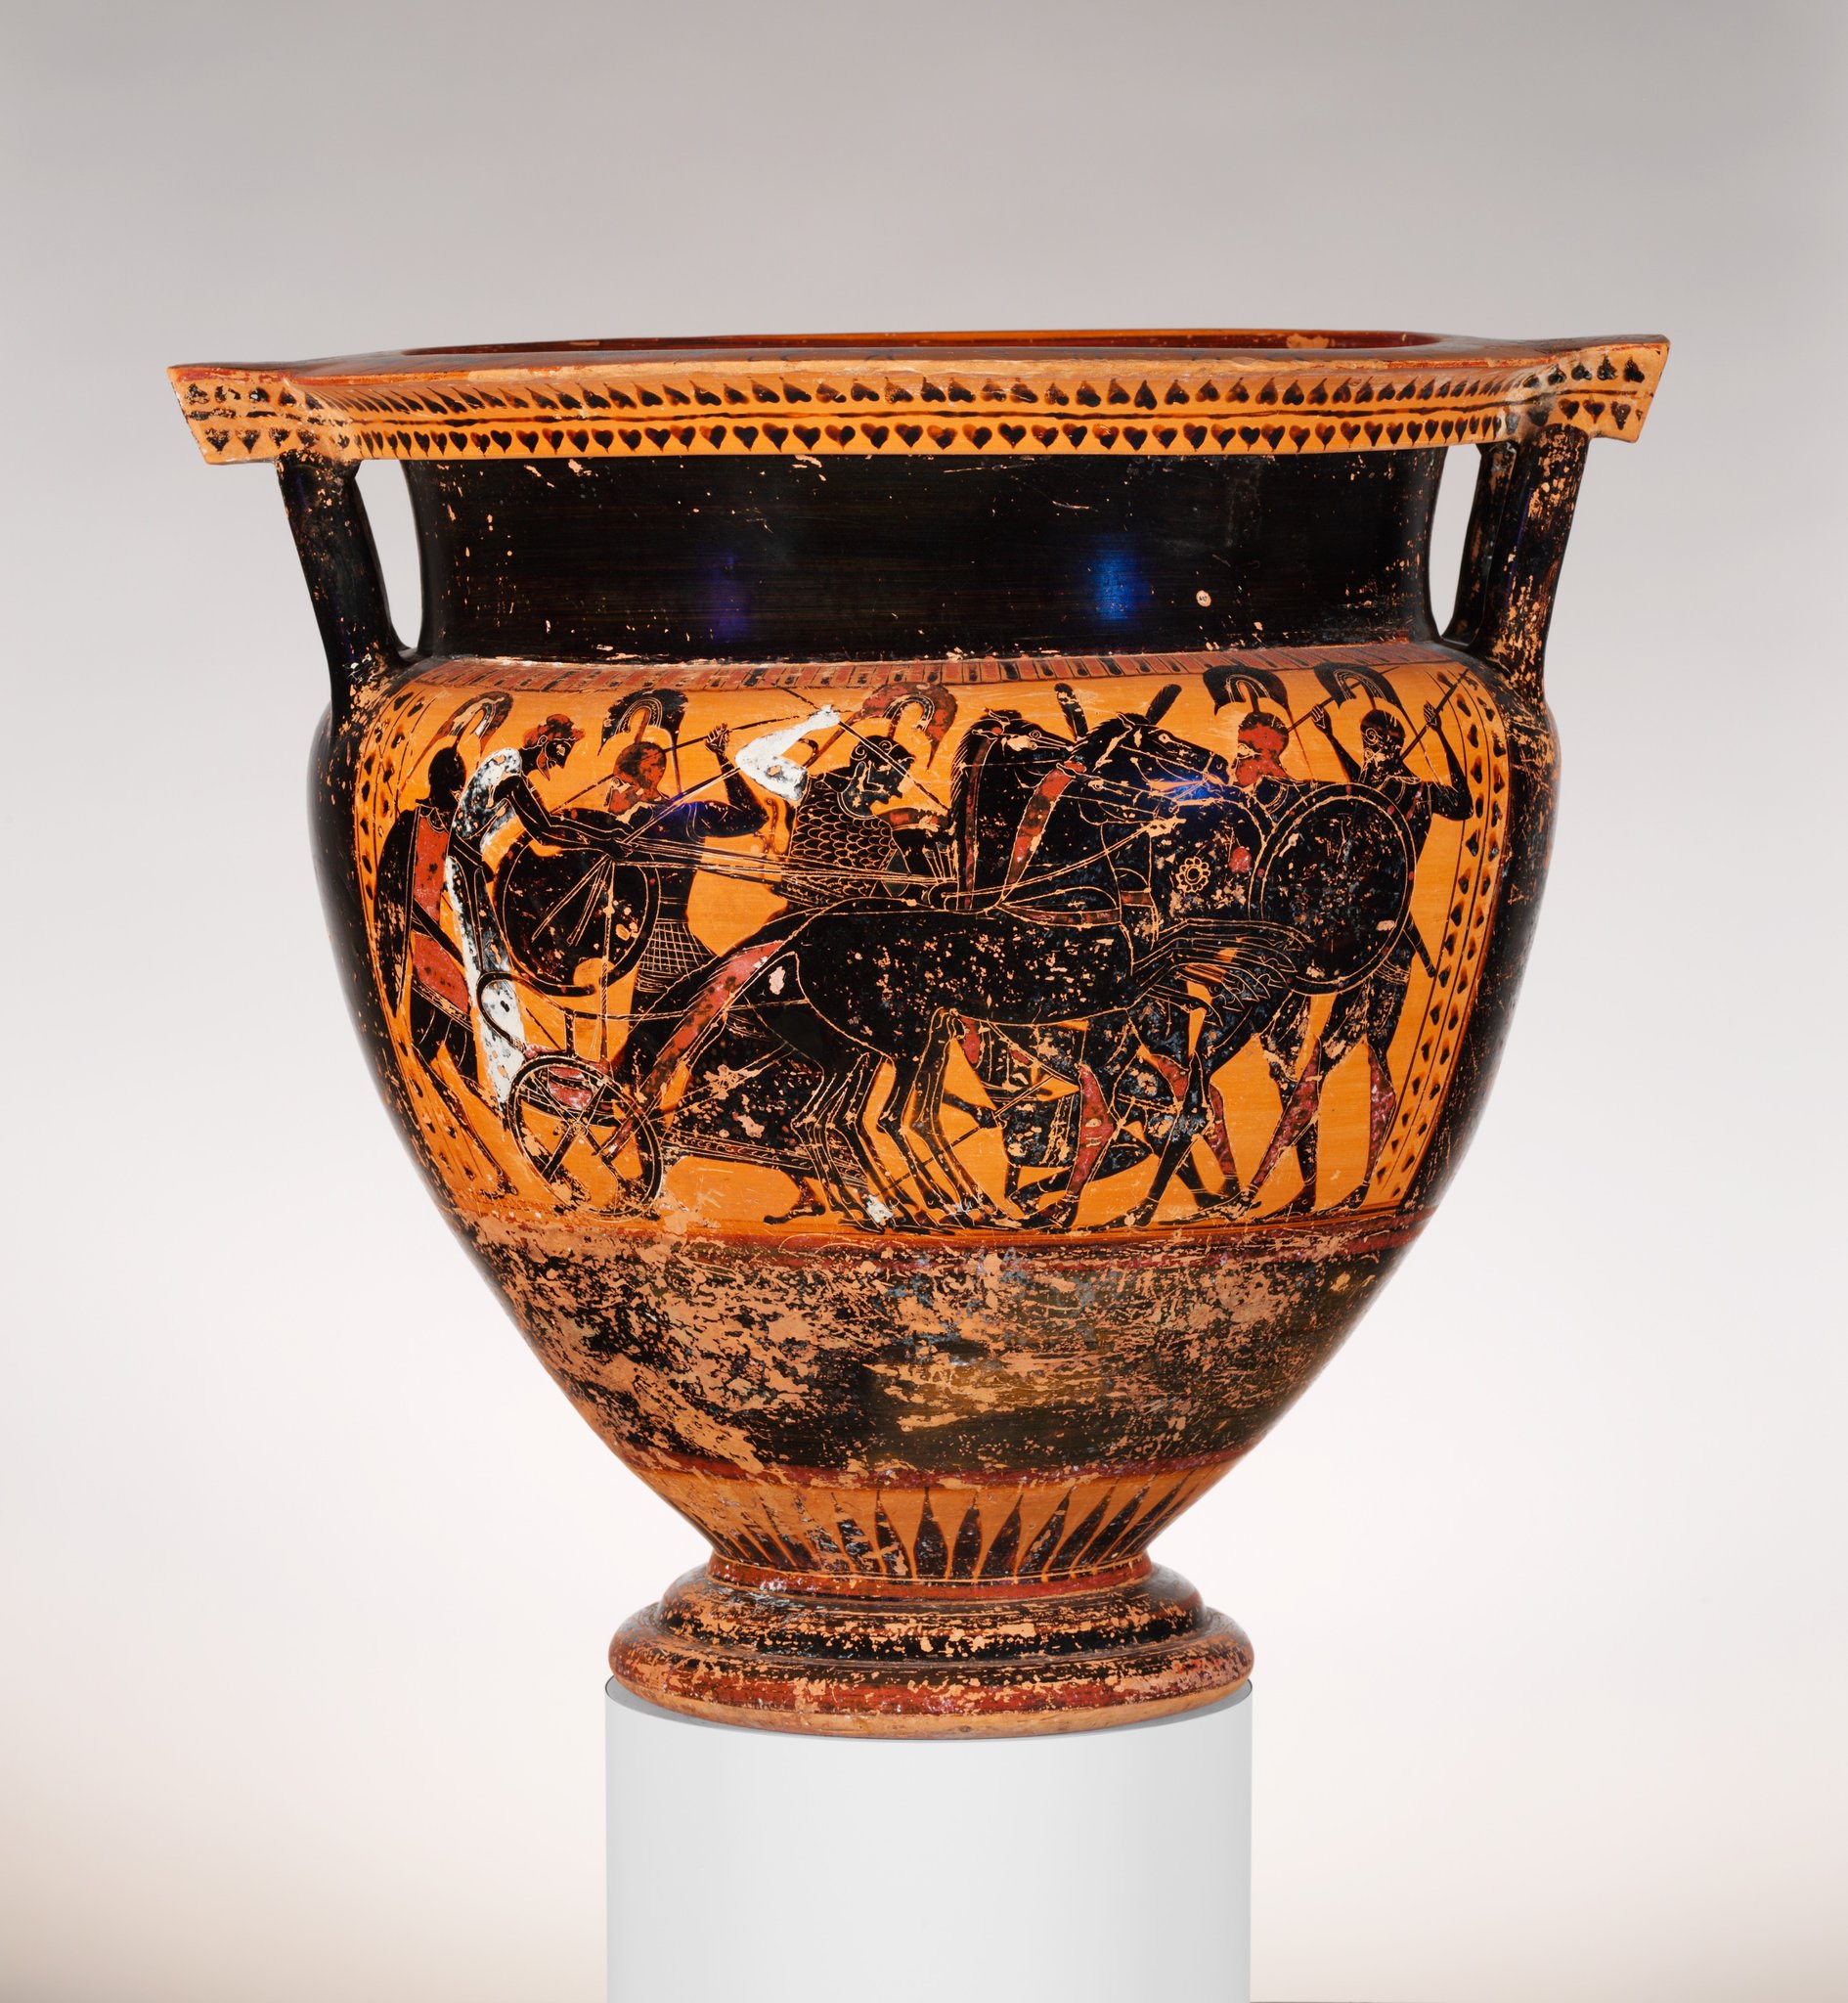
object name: column krater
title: Terracotta column-krater (bowl for mixing wine and water)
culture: greek, attic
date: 540 BCE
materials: terracotta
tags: battles,dionysus,satyrs,horses